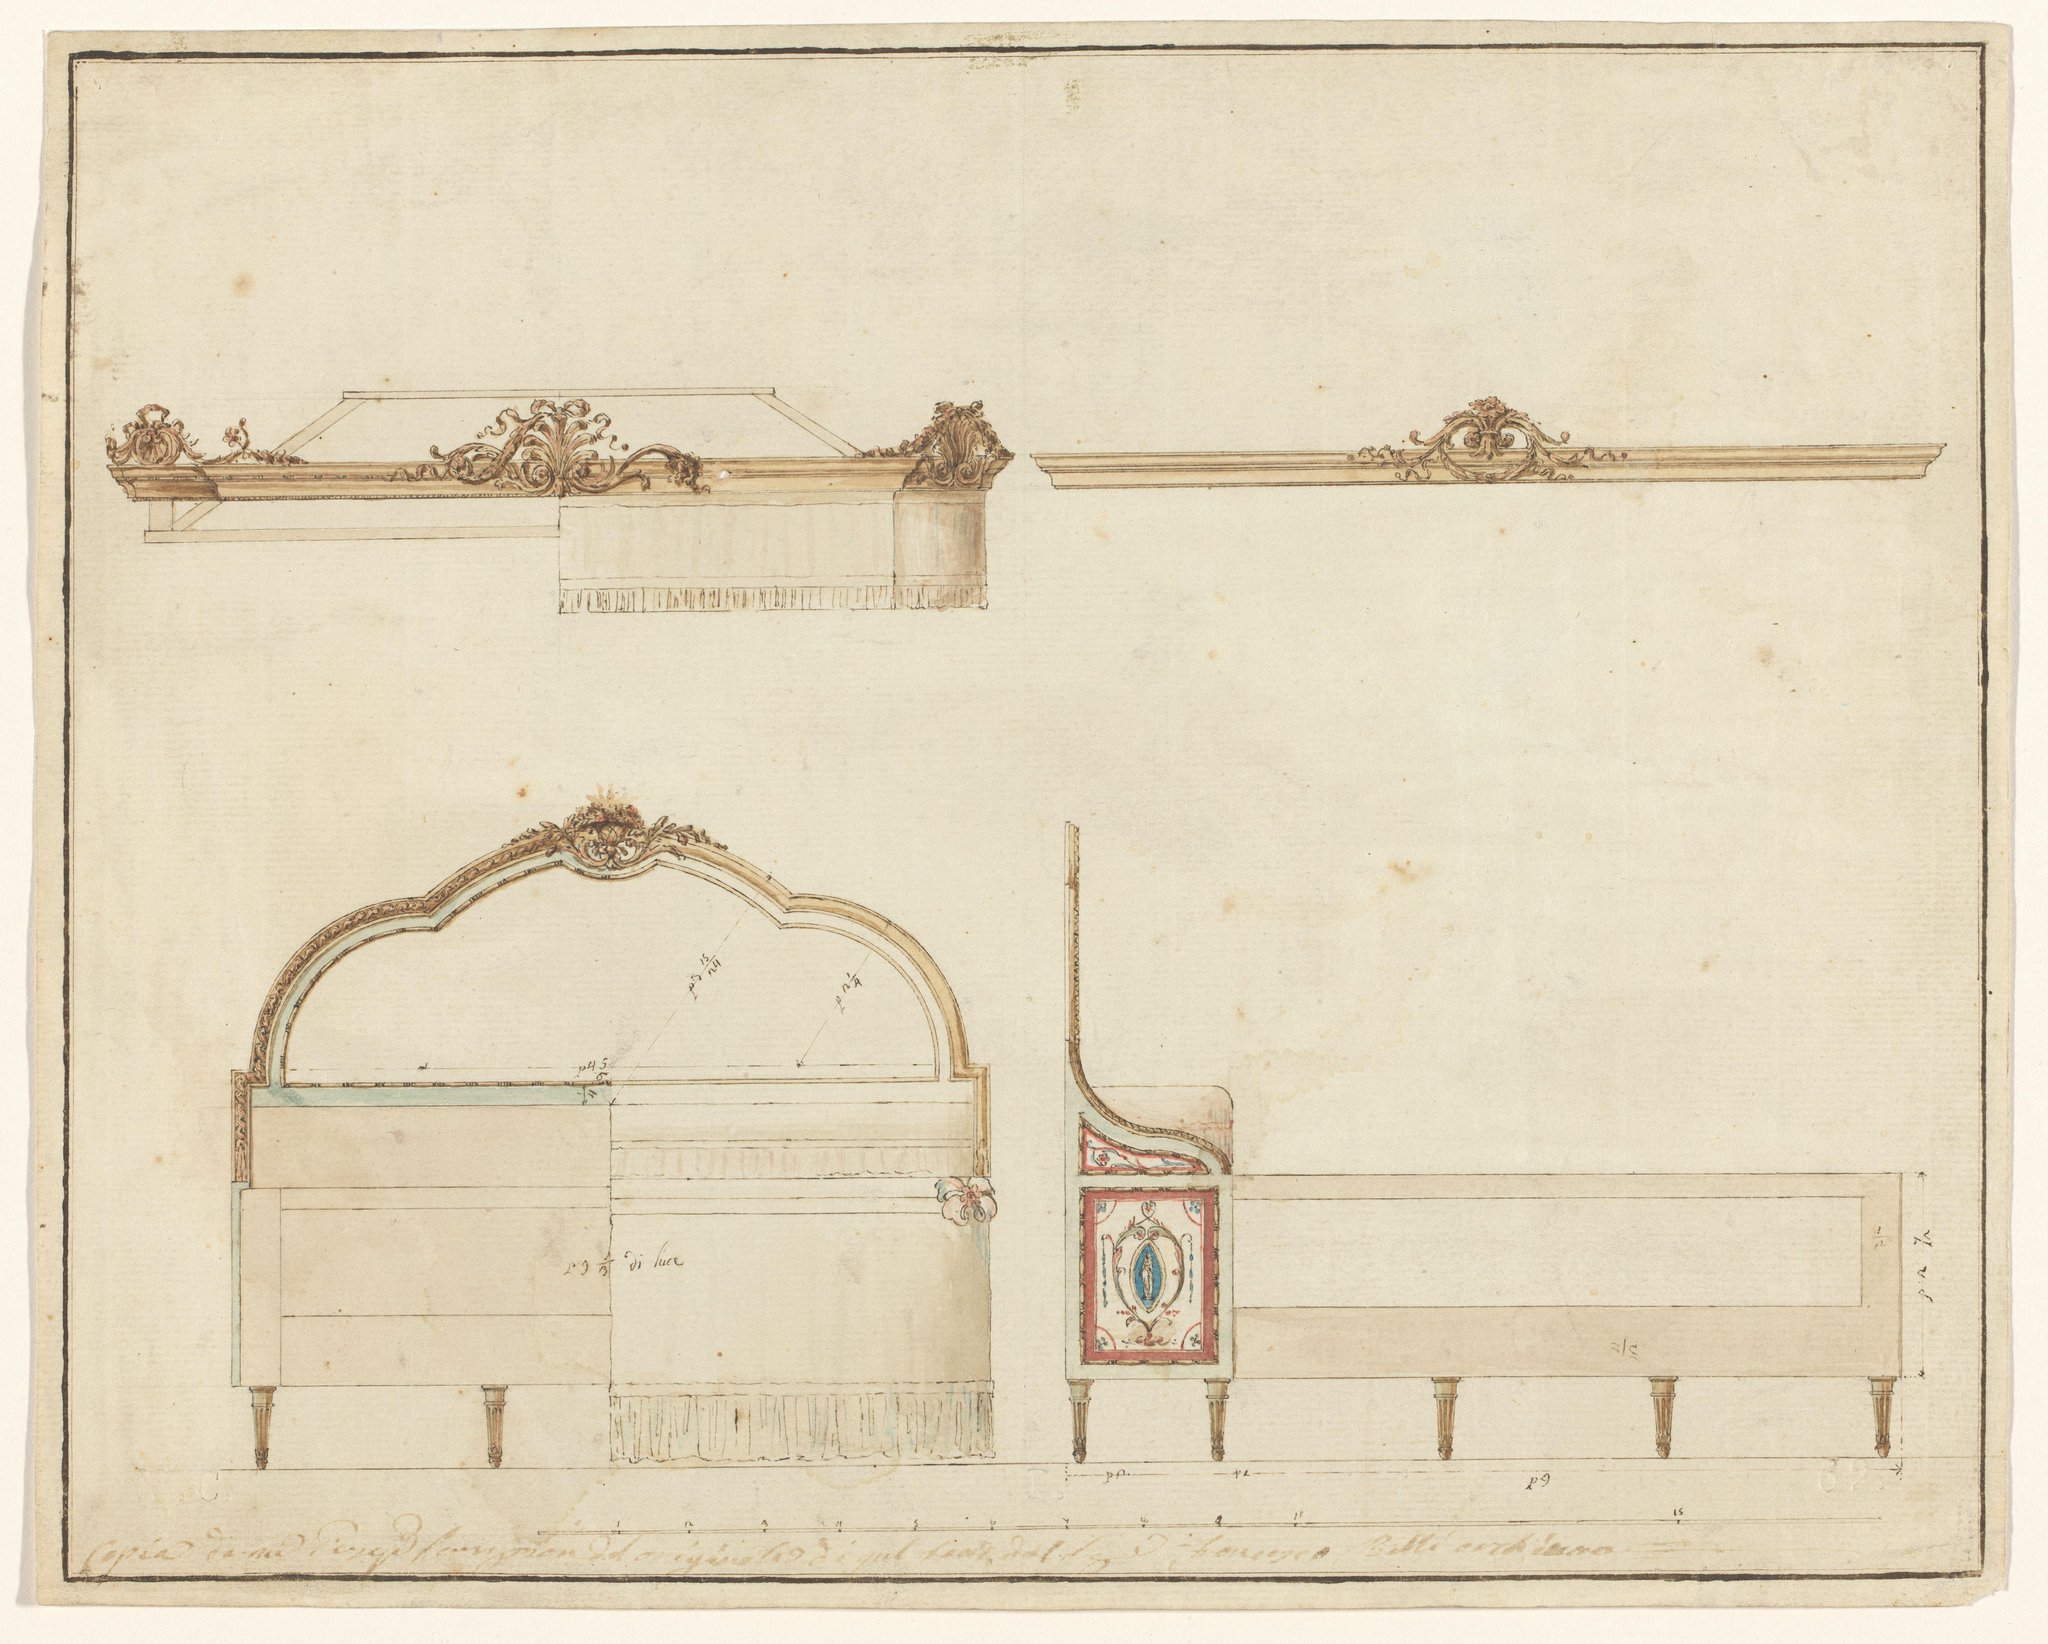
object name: drawing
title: Voorzijde en zijkant van een bed, beide met een hemel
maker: Anonymous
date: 1780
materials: ink, paper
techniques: aquarelle, pen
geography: rome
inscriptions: inscription: ‘Copia da me Gioseppe F[…]man del originale di quel fatto dal Illustre Francesco Belli architetto. In de tekeningen: p 3 15/24 / p 2 ¼ / p 4 5/6 / ¼ / p 9 1/3 di luce / 11/12 / ½ / p 2 ½ . Onder langs schaal met 1 2 3 4 5 6 7 8 9 10 15.’, scale: ‘1 2 3 4 5 6 7 8 9 10 15’, watermark: ‘lelie onder kroon met lelie.’, check stamp: ‘M.C. / B. / 32’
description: De voorzijde met links en rechts alternatieve oplossingen, en rechts de textiele bekleding.